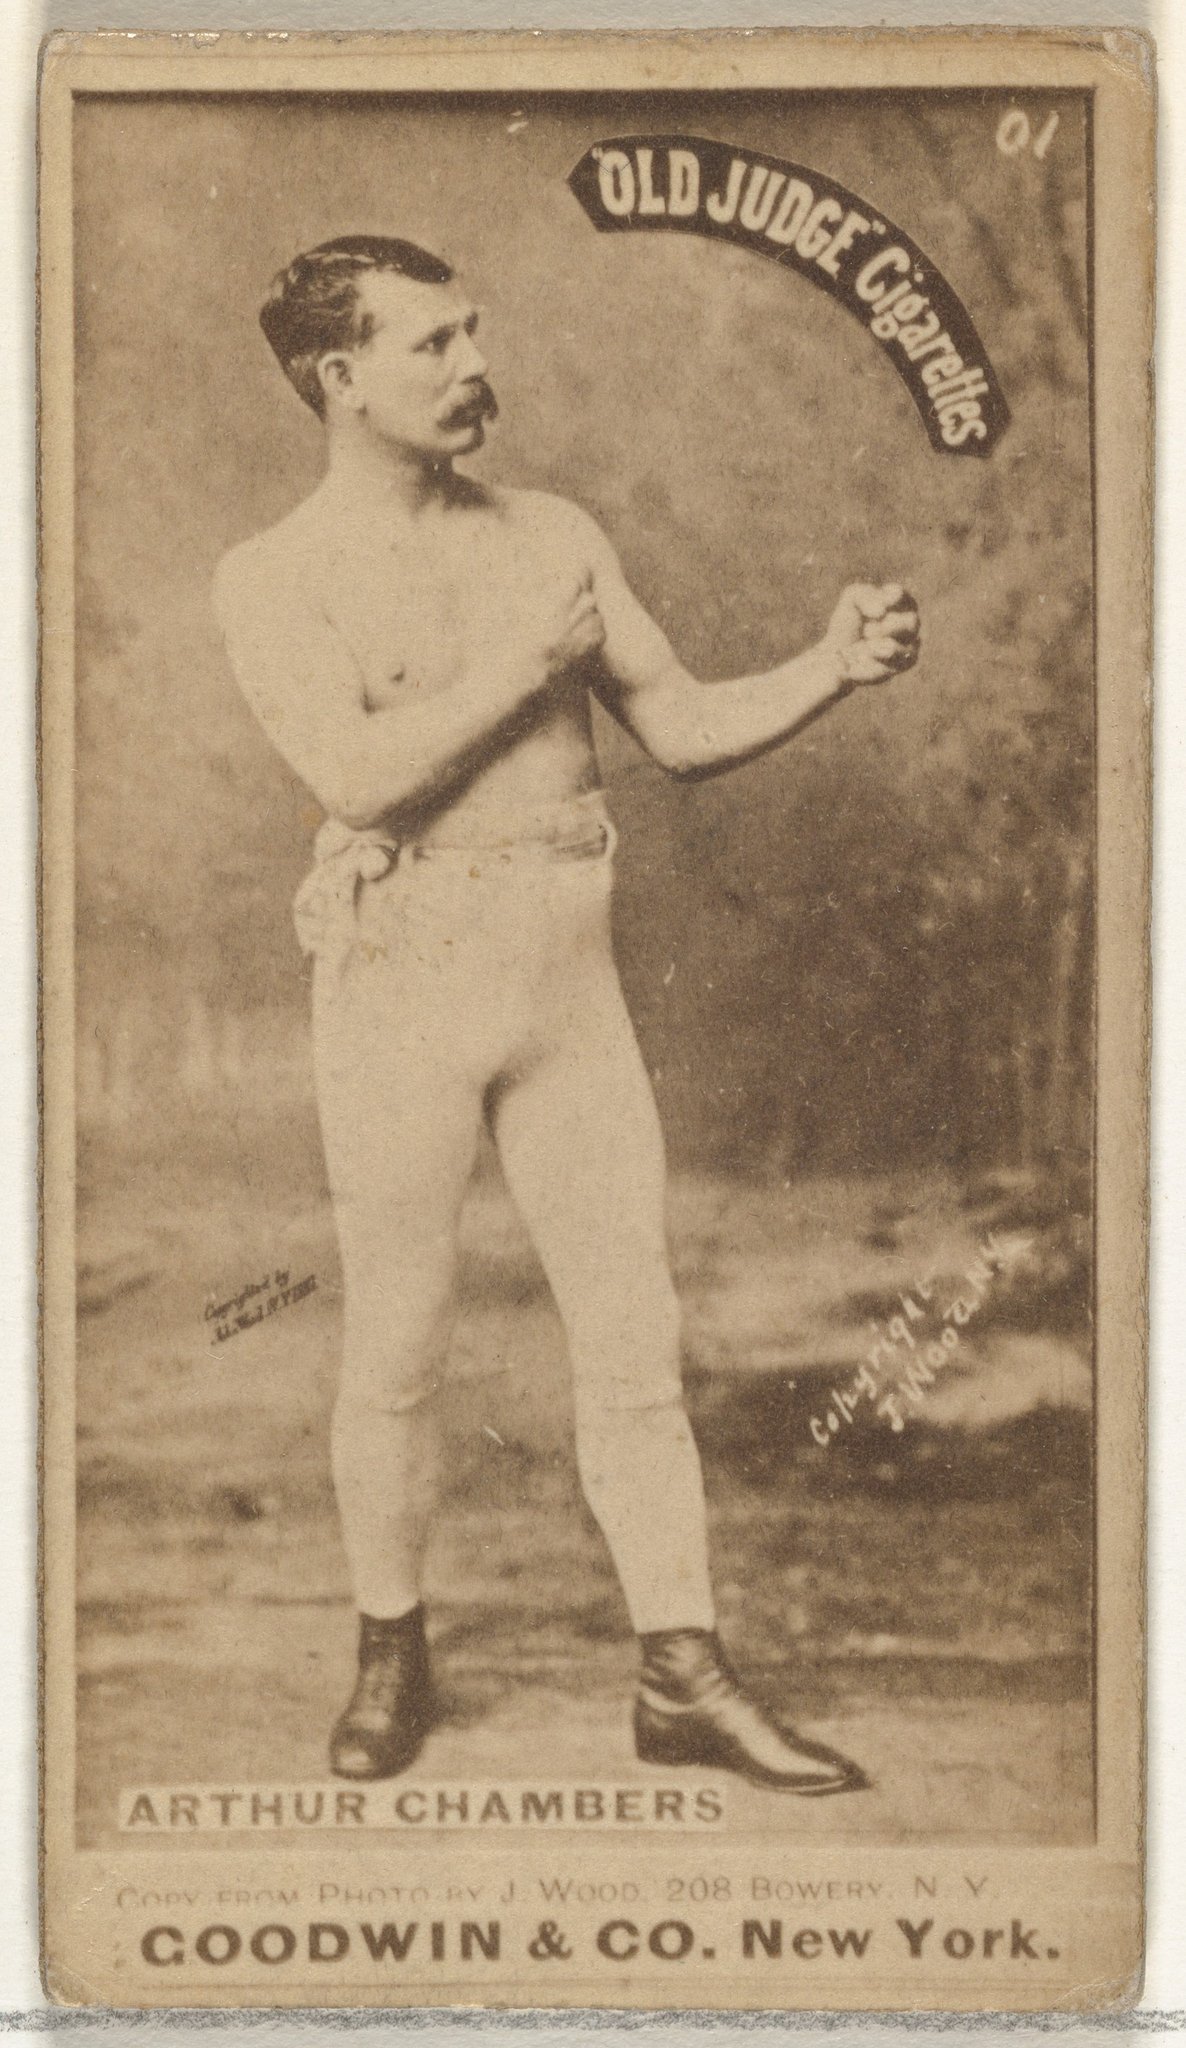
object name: photograph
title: Arthur Chambers, from the Celebrities and Prizefighters series (N174) for Old Judge Cigarettes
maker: goodwin & company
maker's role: publisher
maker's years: 1850-1950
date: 1887-1888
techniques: albumen silver print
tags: men,portraits,boxing,athletes